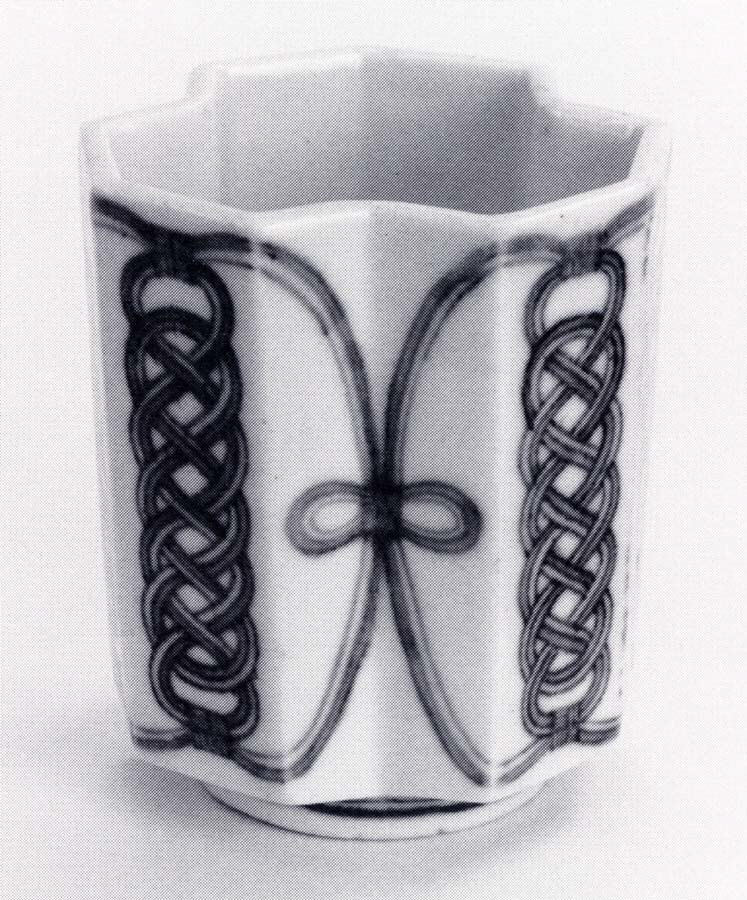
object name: cup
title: Polyhedral Cup with Decoration of Knotted Cord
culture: japanese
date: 1688-1704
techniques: underglaze